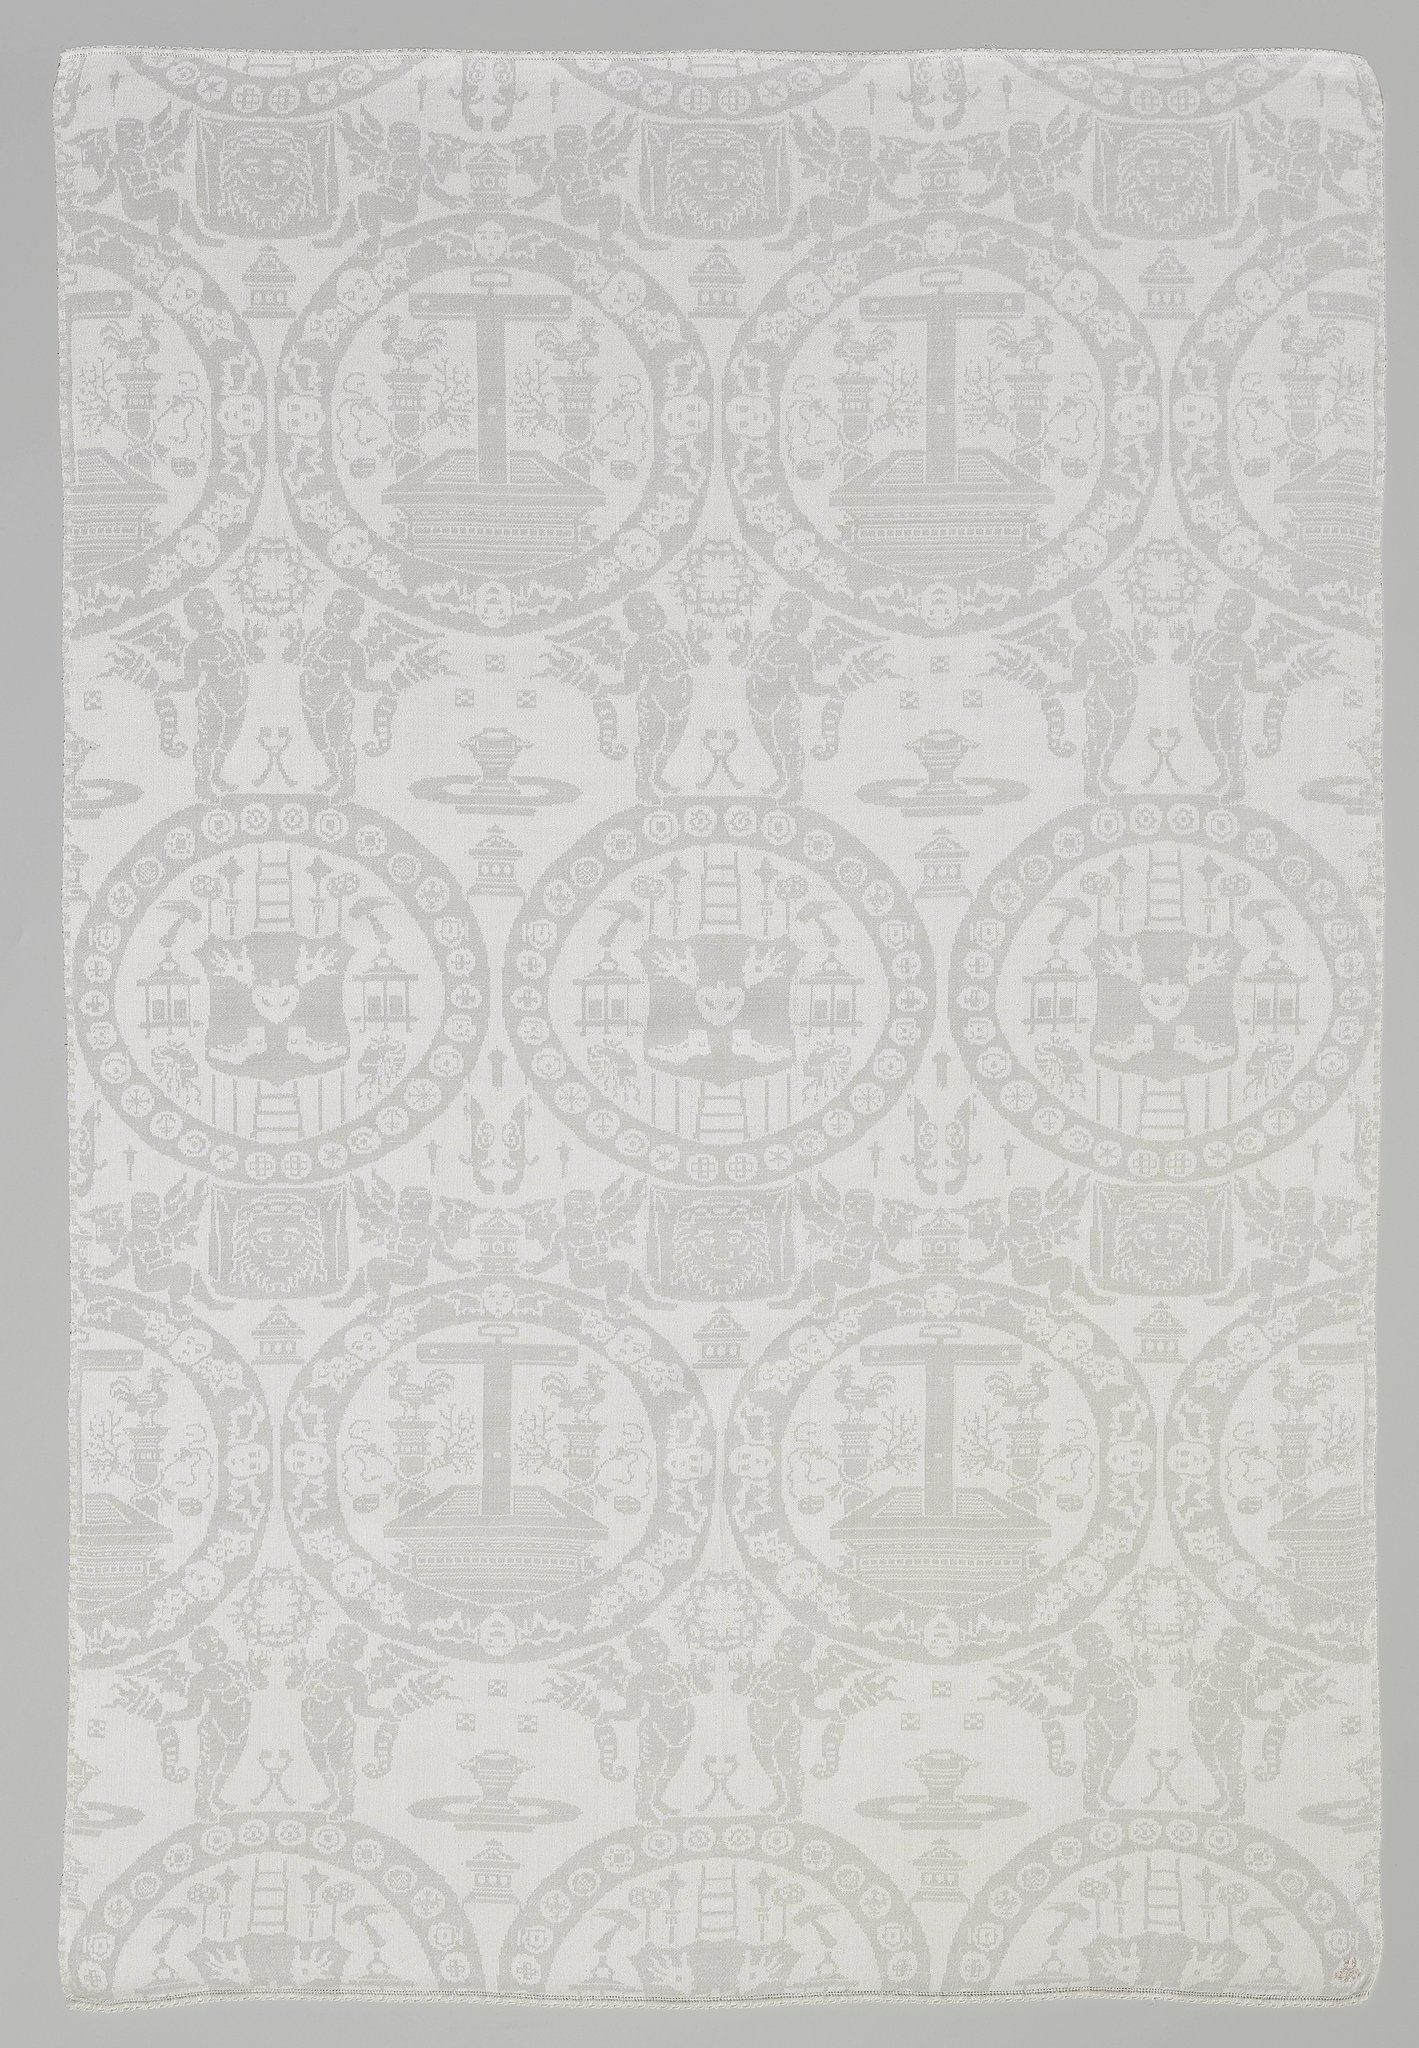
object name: napkin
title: Servet met ingeweven voorstellingen van de passiewerktuigen van Christus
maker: Anonymous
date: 1550-1599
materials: linen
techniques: damask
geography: flanders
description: Servet van wit linnen, met ingeweven voorstellingen van de passiewerktuigen van Christus, aan de onder- en bovenzijde afgezet met tressen.